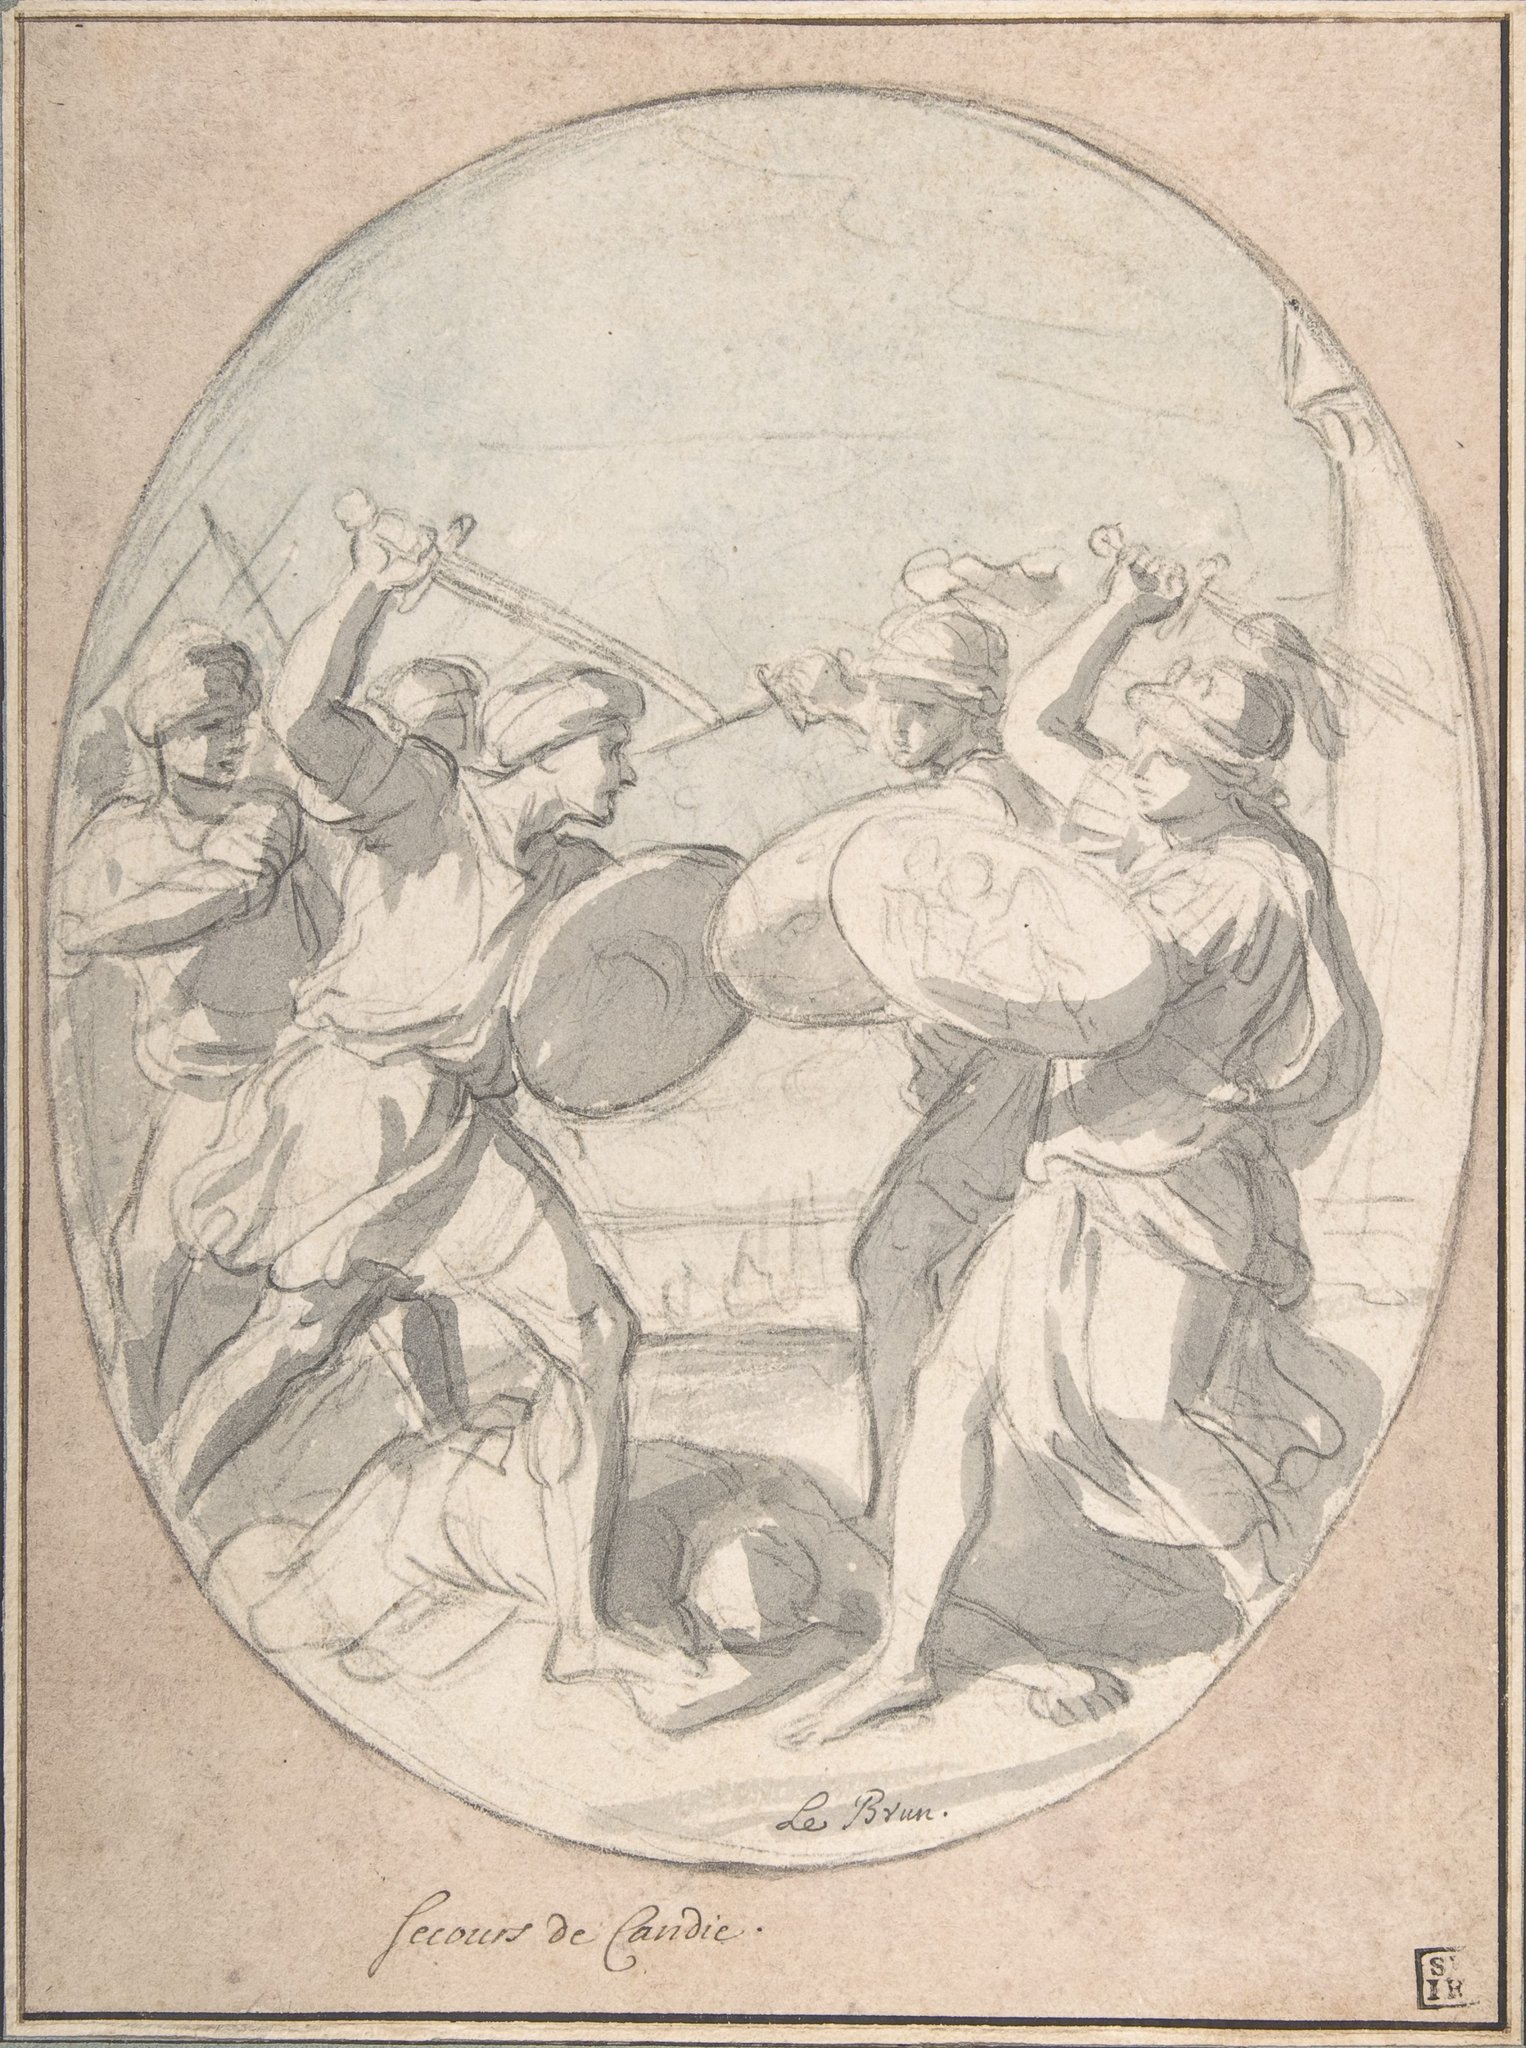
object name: drawing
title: The Relief of Candia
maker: charles le brun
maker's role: artist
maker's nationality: french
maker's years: 1619-1690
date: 1601-1700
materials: chalk, paper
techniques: brush, wash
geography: france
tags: battles,shields,swords,men